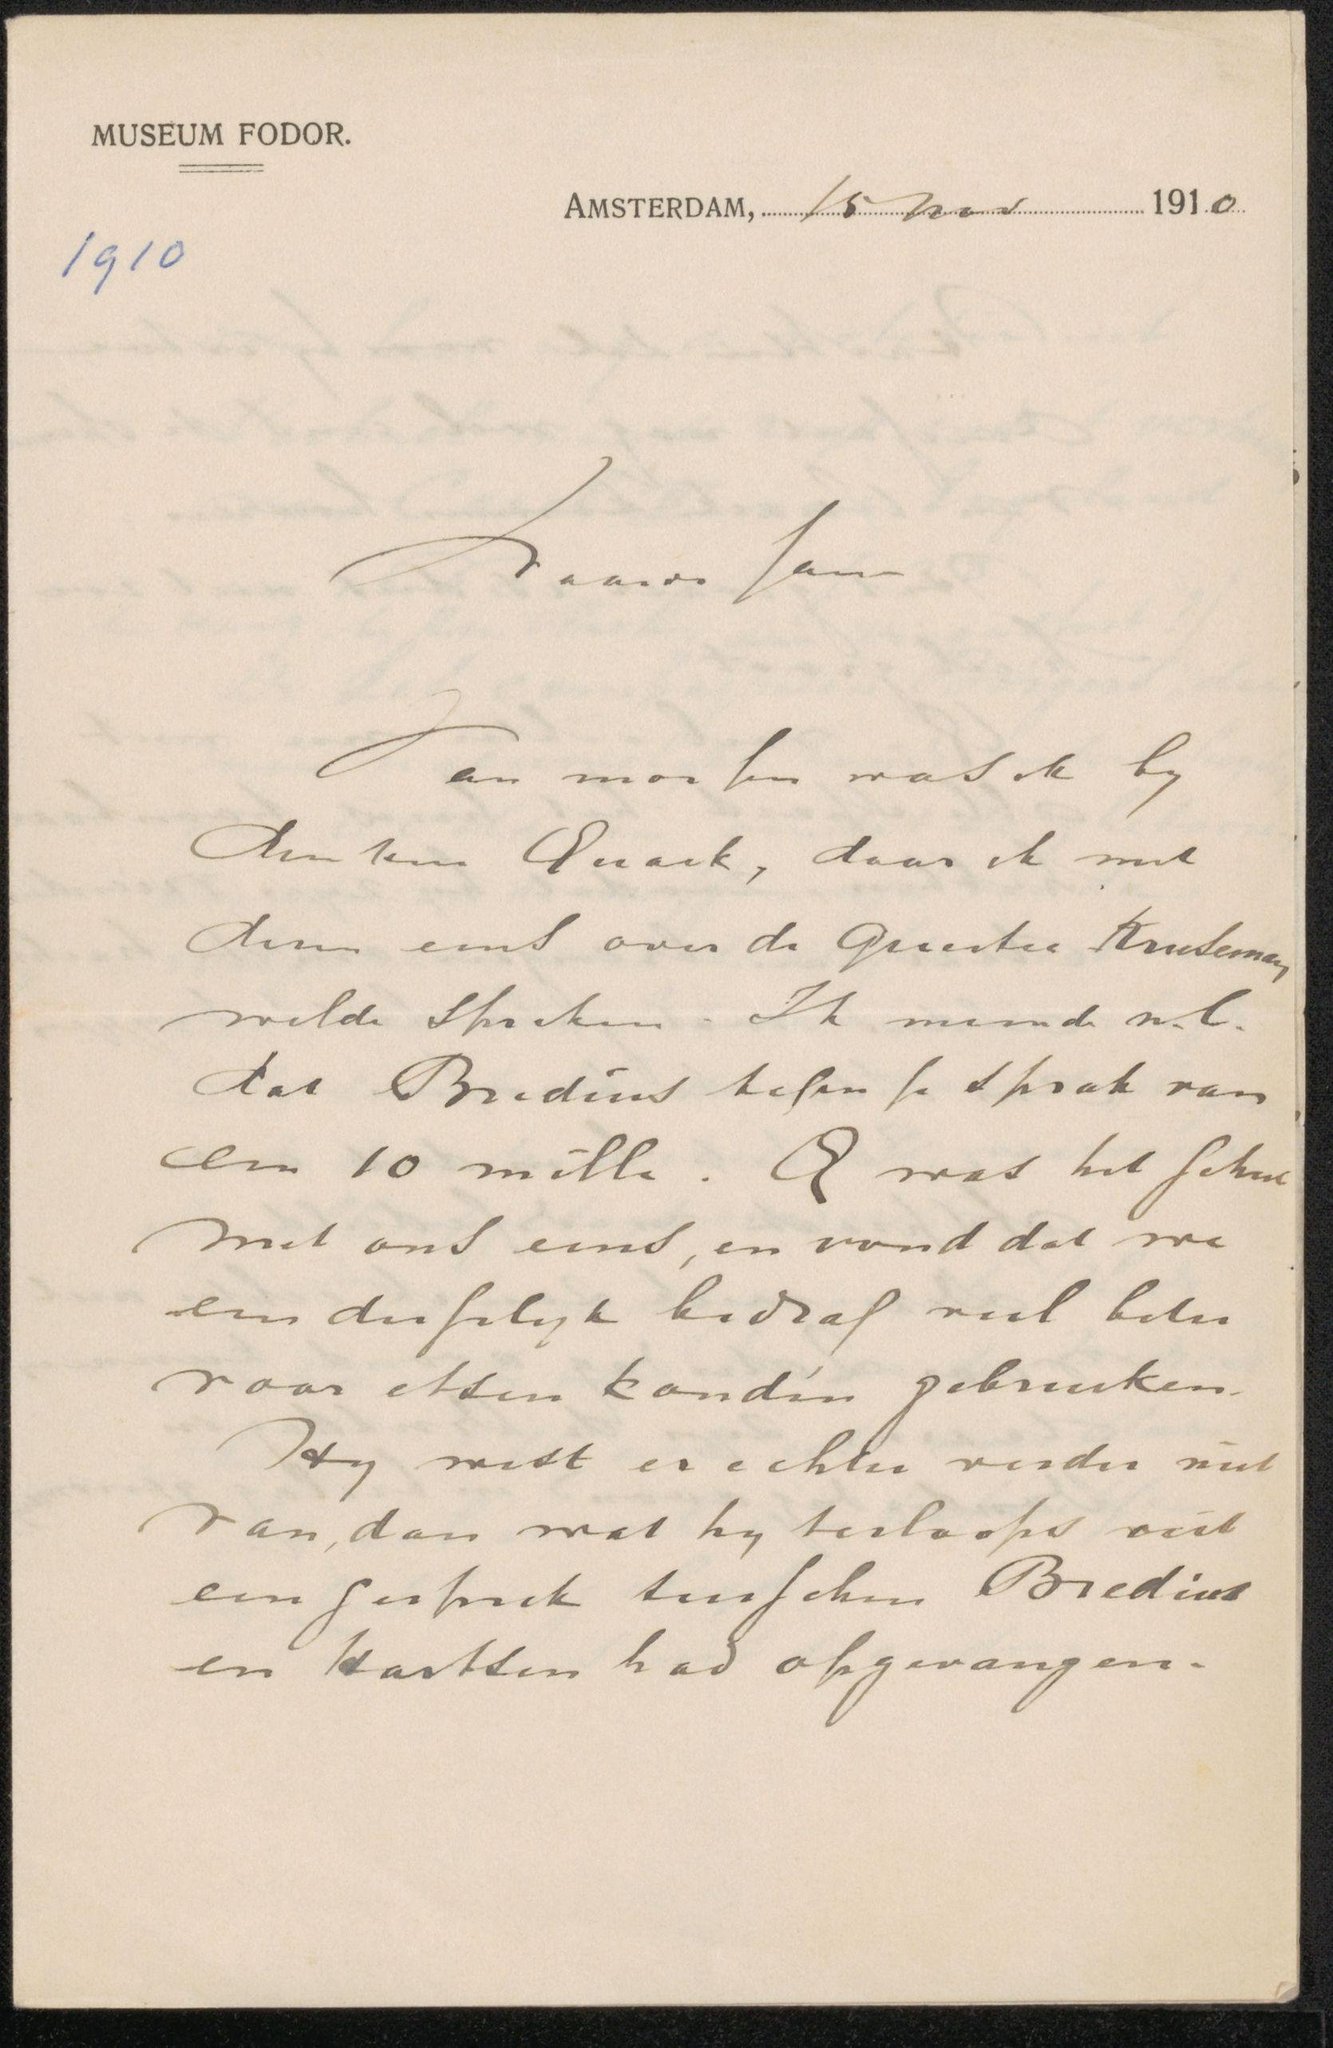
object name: letter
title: Brief aan Jan Veth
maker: cornelis gerardus t hooft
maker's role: draughtsman, painter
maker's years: 1866-1936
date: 1910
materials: ink, paper, pencil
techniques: pen, printing, writing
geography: amsterdam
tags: print maker, designer, jan veth, hendrick peter godfried quack, abraham bredius, the graphic arts, anonymous historical person portrayed, painting (including book-illumination, miniature-painting), art collecting, money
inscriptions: collector's mark: ‘RPK’